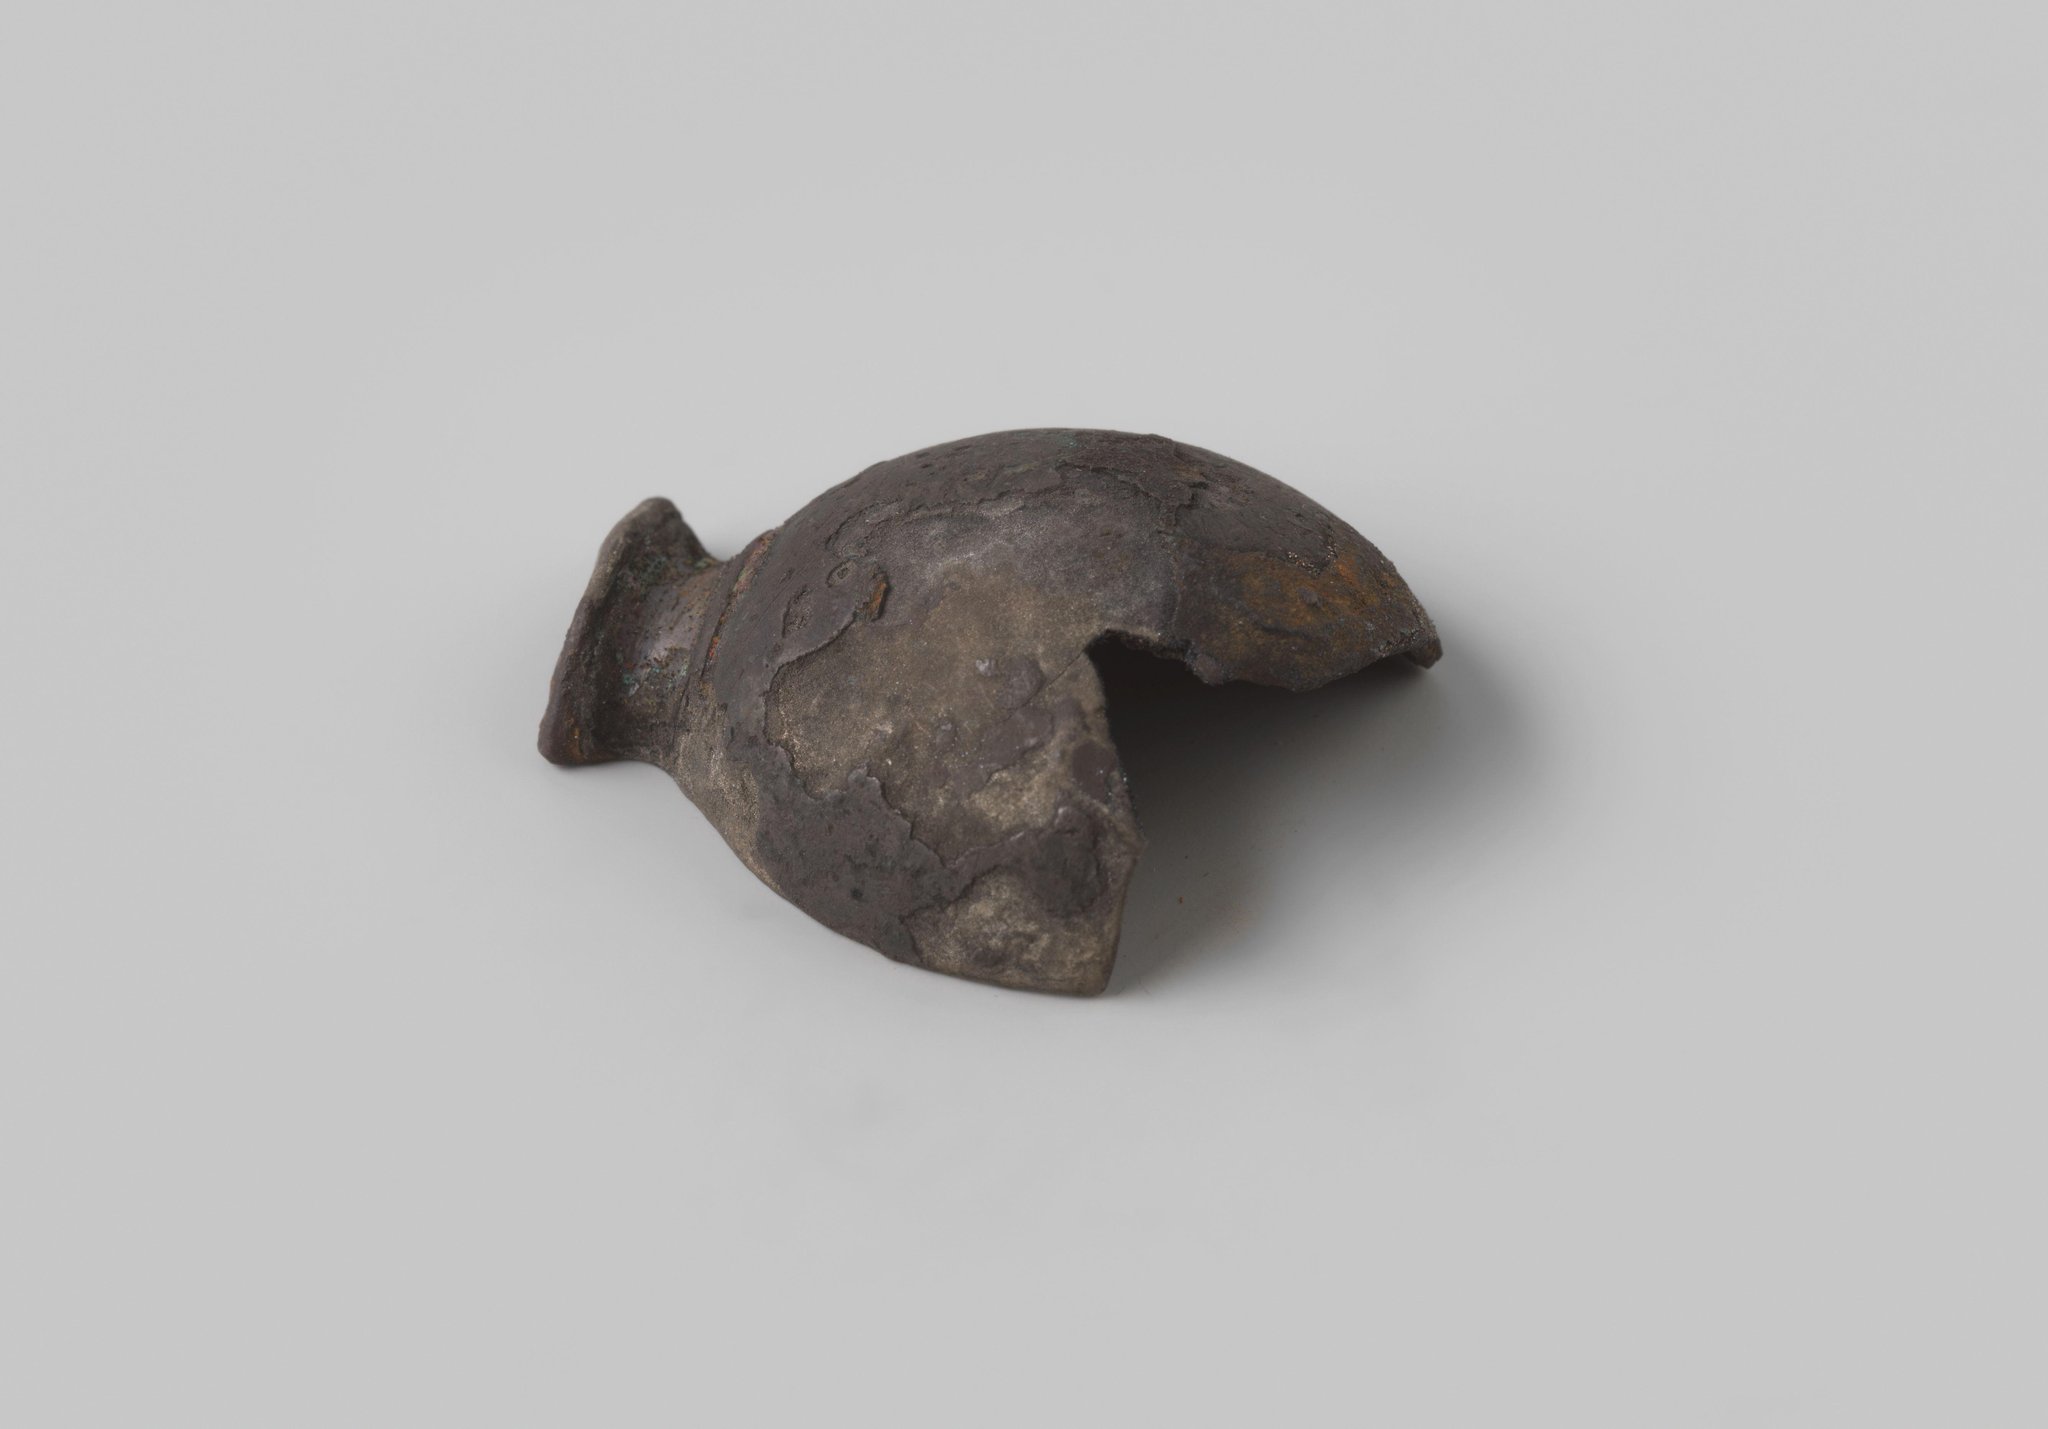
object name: hilt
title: Fragment zadelknop van gevest uit het wrak van de Oost-Indiëvaarder Hollandia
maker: Anonymous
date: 1700-1743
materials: silver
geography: netherlands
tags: verenigde oostindische compagnie, hollandia (schip), annet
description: Hilt, pommel, fragm, half part, ball-shaped, plain, spool-shaped stub for tang button on top, hollow, eroded.